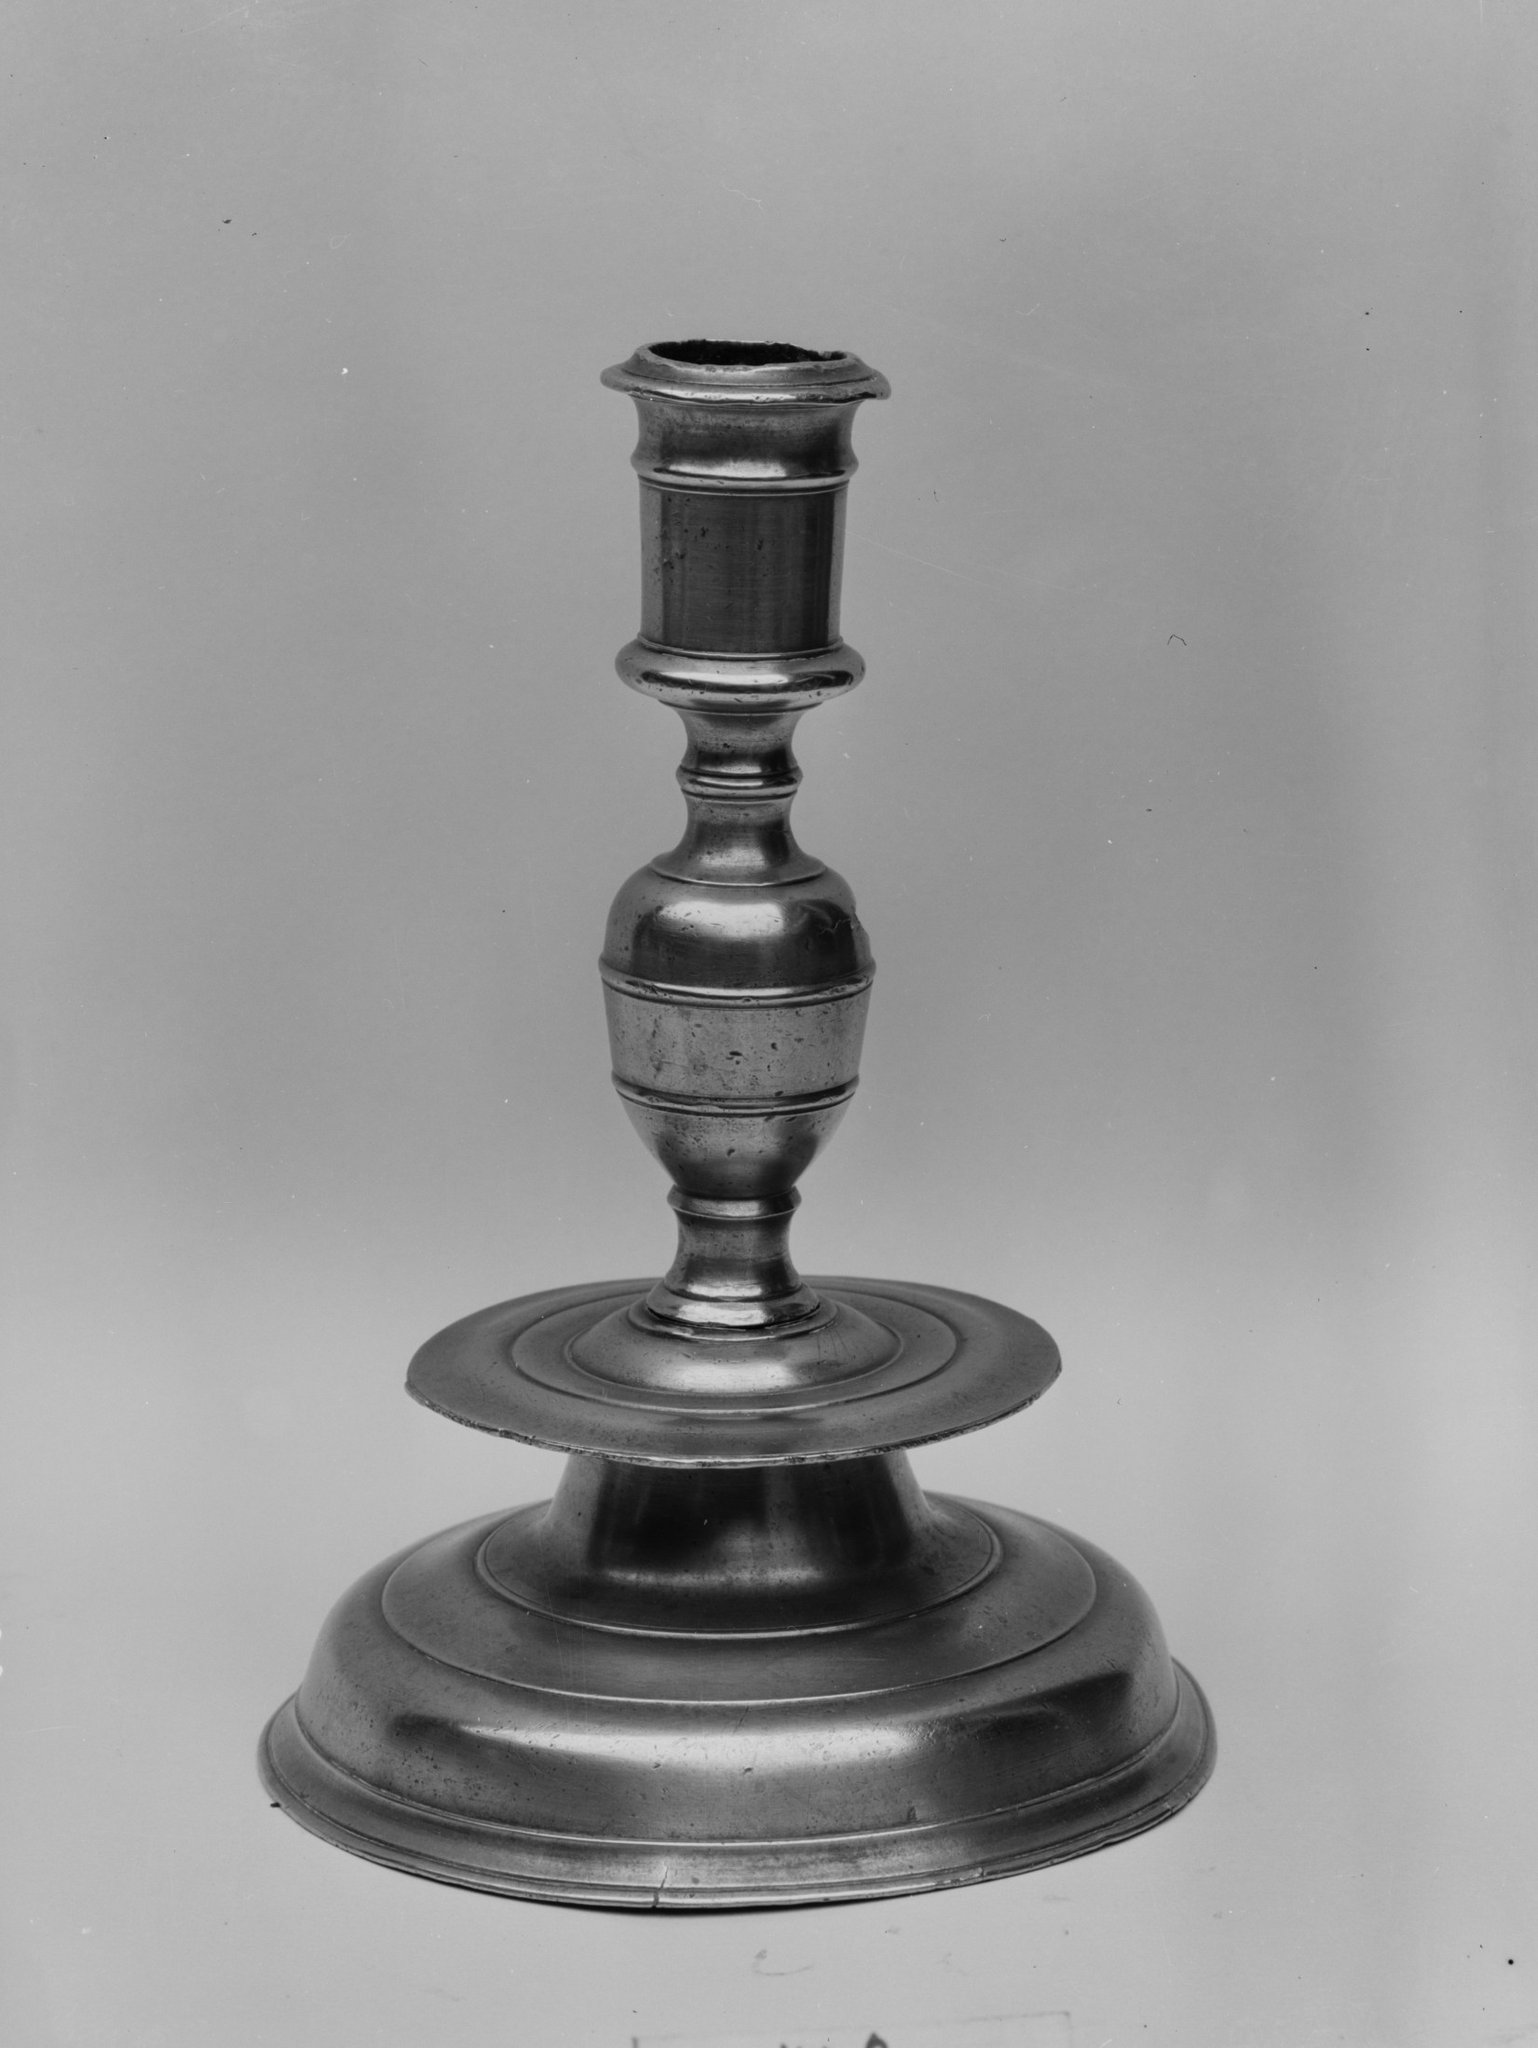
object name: candlestick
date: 1600-1700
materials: brass